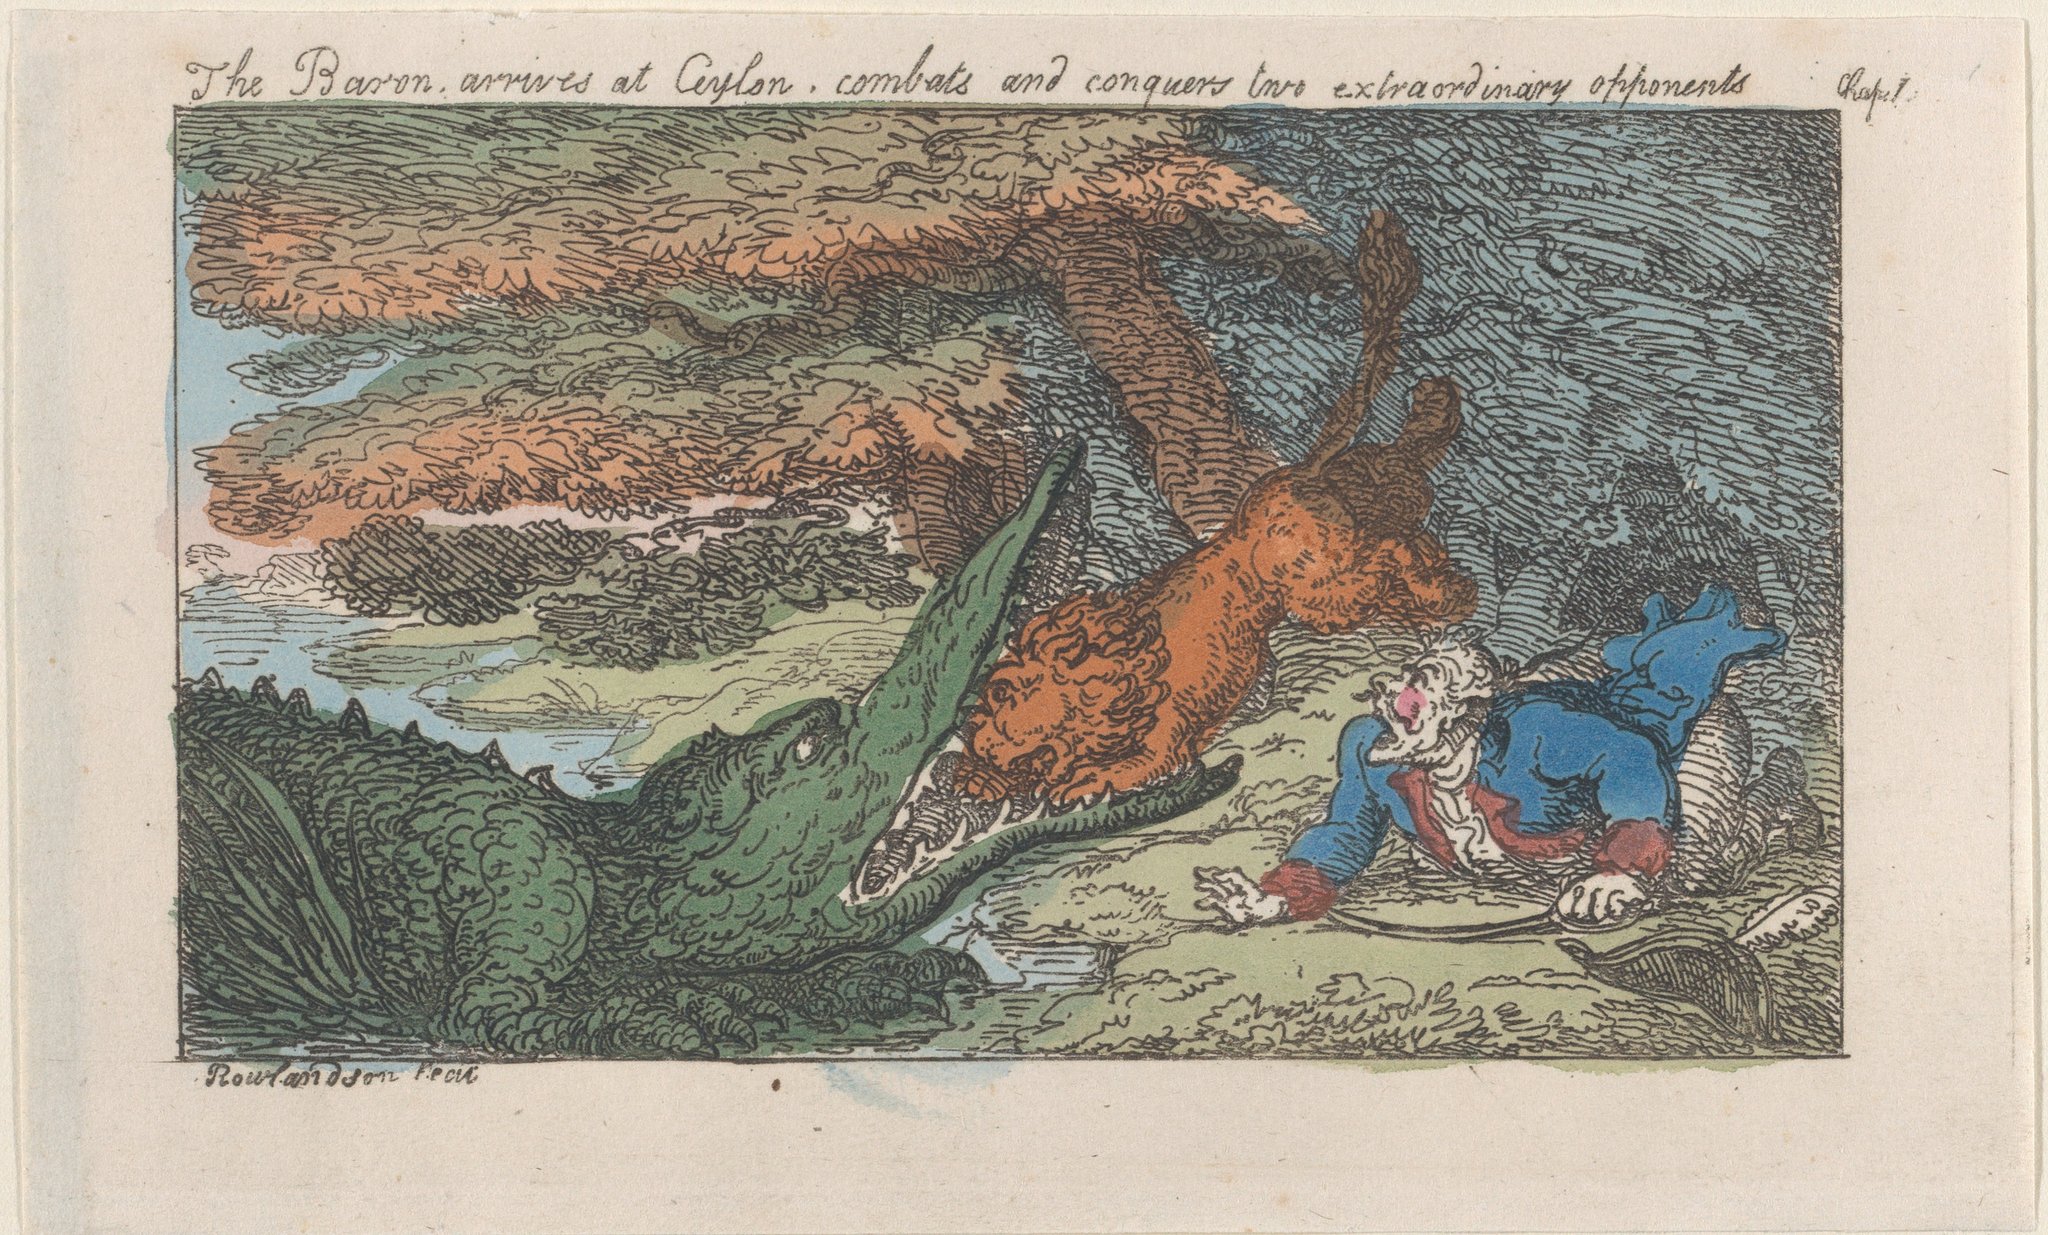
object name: print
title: The Baron arrives at Ceylon, combats and conquers two extraordinary opponents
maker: thomas rowlandson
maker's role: artist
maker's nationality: british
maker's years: 1757-1827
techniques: etching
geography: london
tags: men,crocodiles,lions